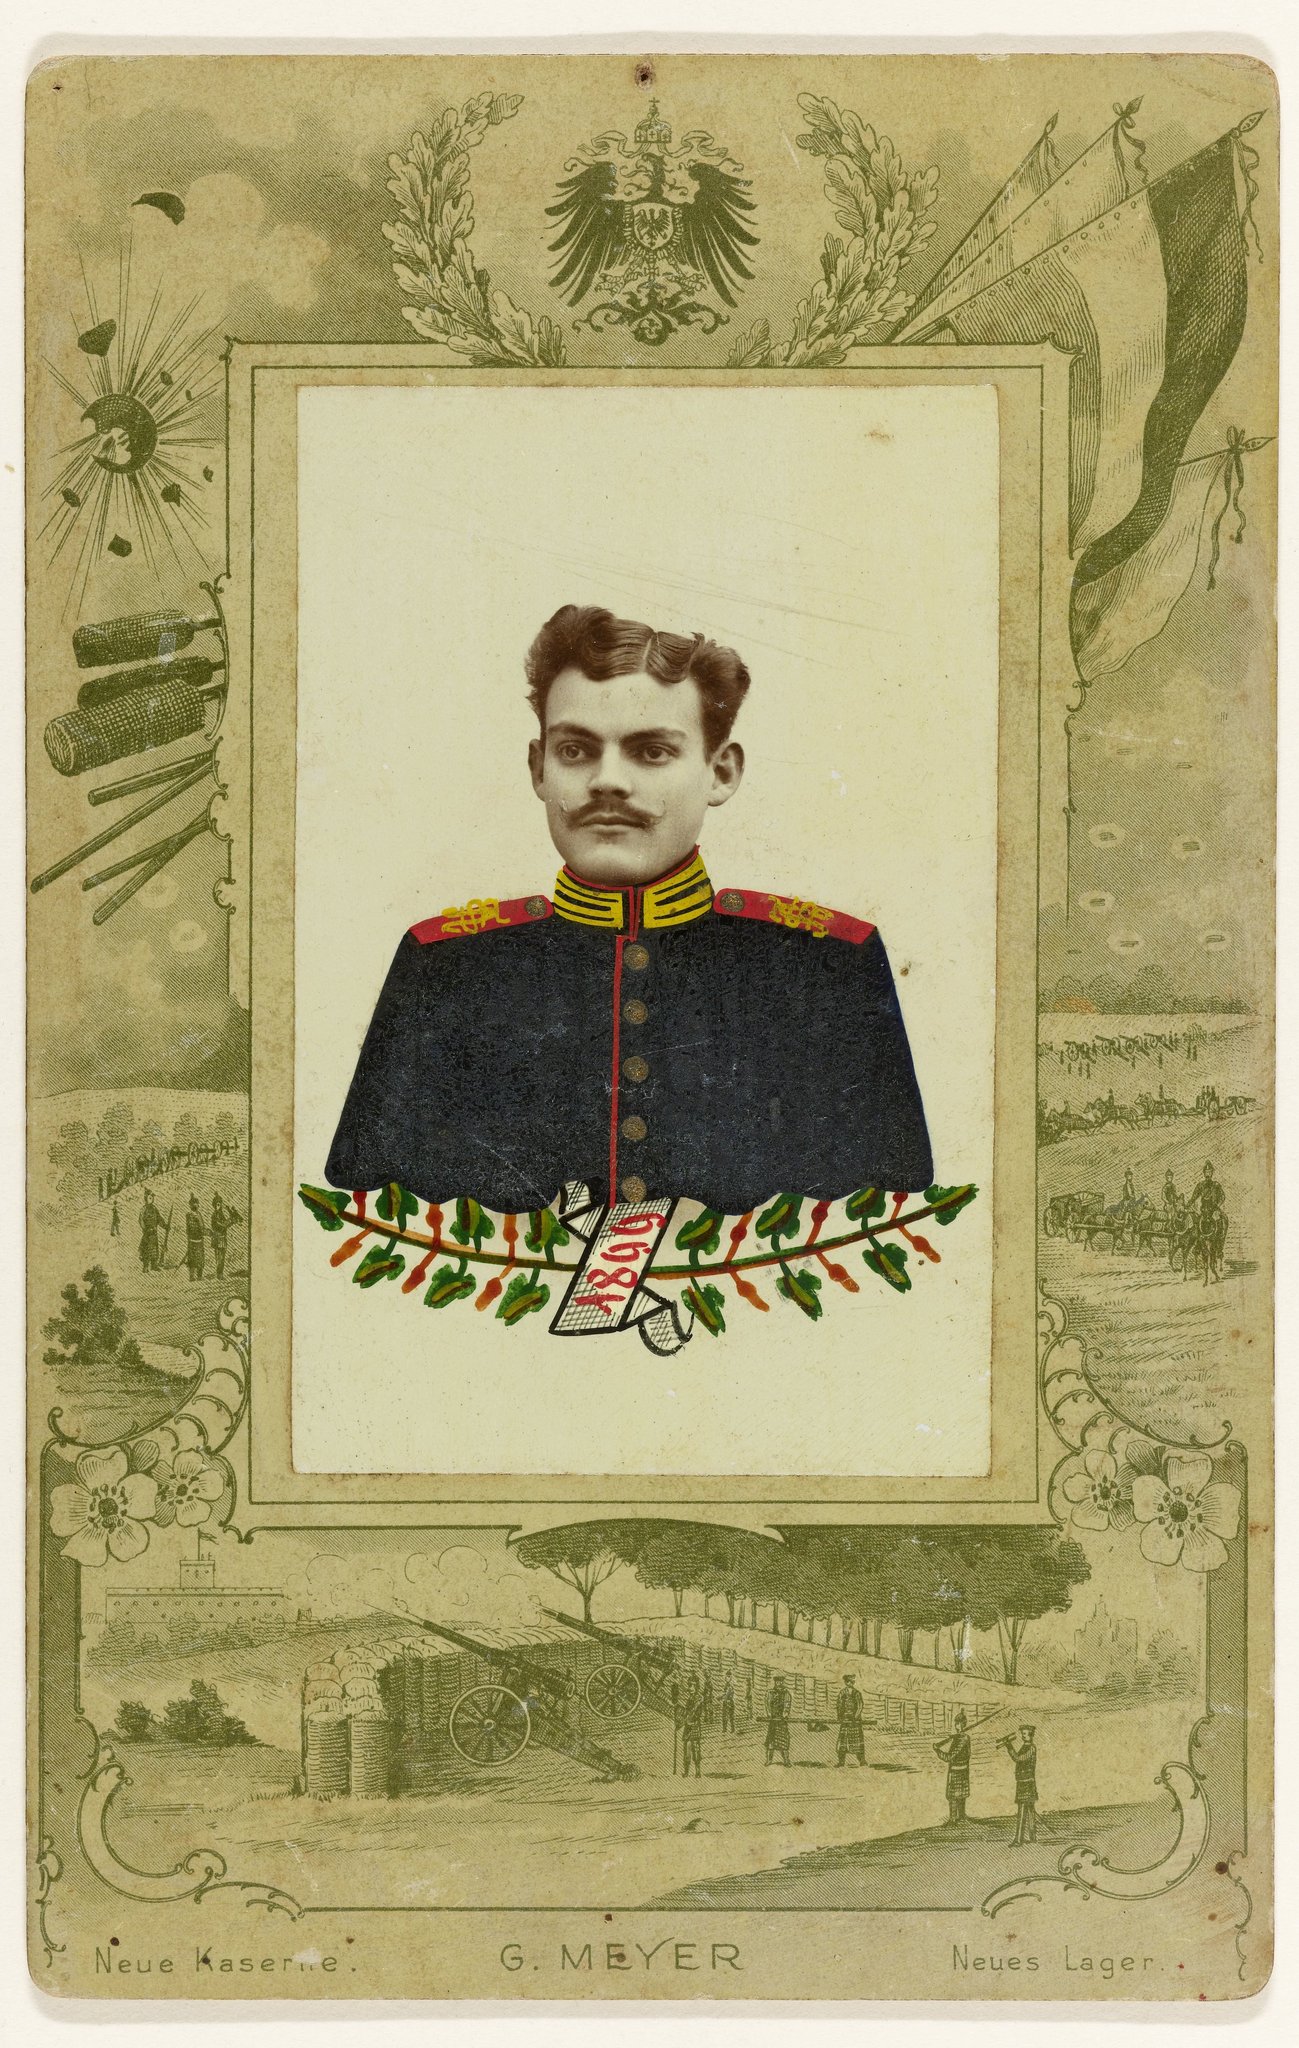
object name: cabinet photograph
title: Portret van Duitse militair M. Roth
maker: g. meyer (fotograaf)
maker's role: fotograaf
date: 1899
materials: paper, cardboard, paint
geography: jüterbog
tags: historical persons, the soldier; the soldier's life, (military) uniforms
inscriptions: inscription: ‘Meinem lieben Braut/ zum Andenken an meinem/ 22. Geburtstag./ Jüterbog, den 30. Januar 1899./ M. Roth.’, inscription: ‘Neue Kaserne./ G. MEYER/ Neues Lager.’, date: ‘1899’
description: Met randvoorstellingen van scènes uit het militaire leven.